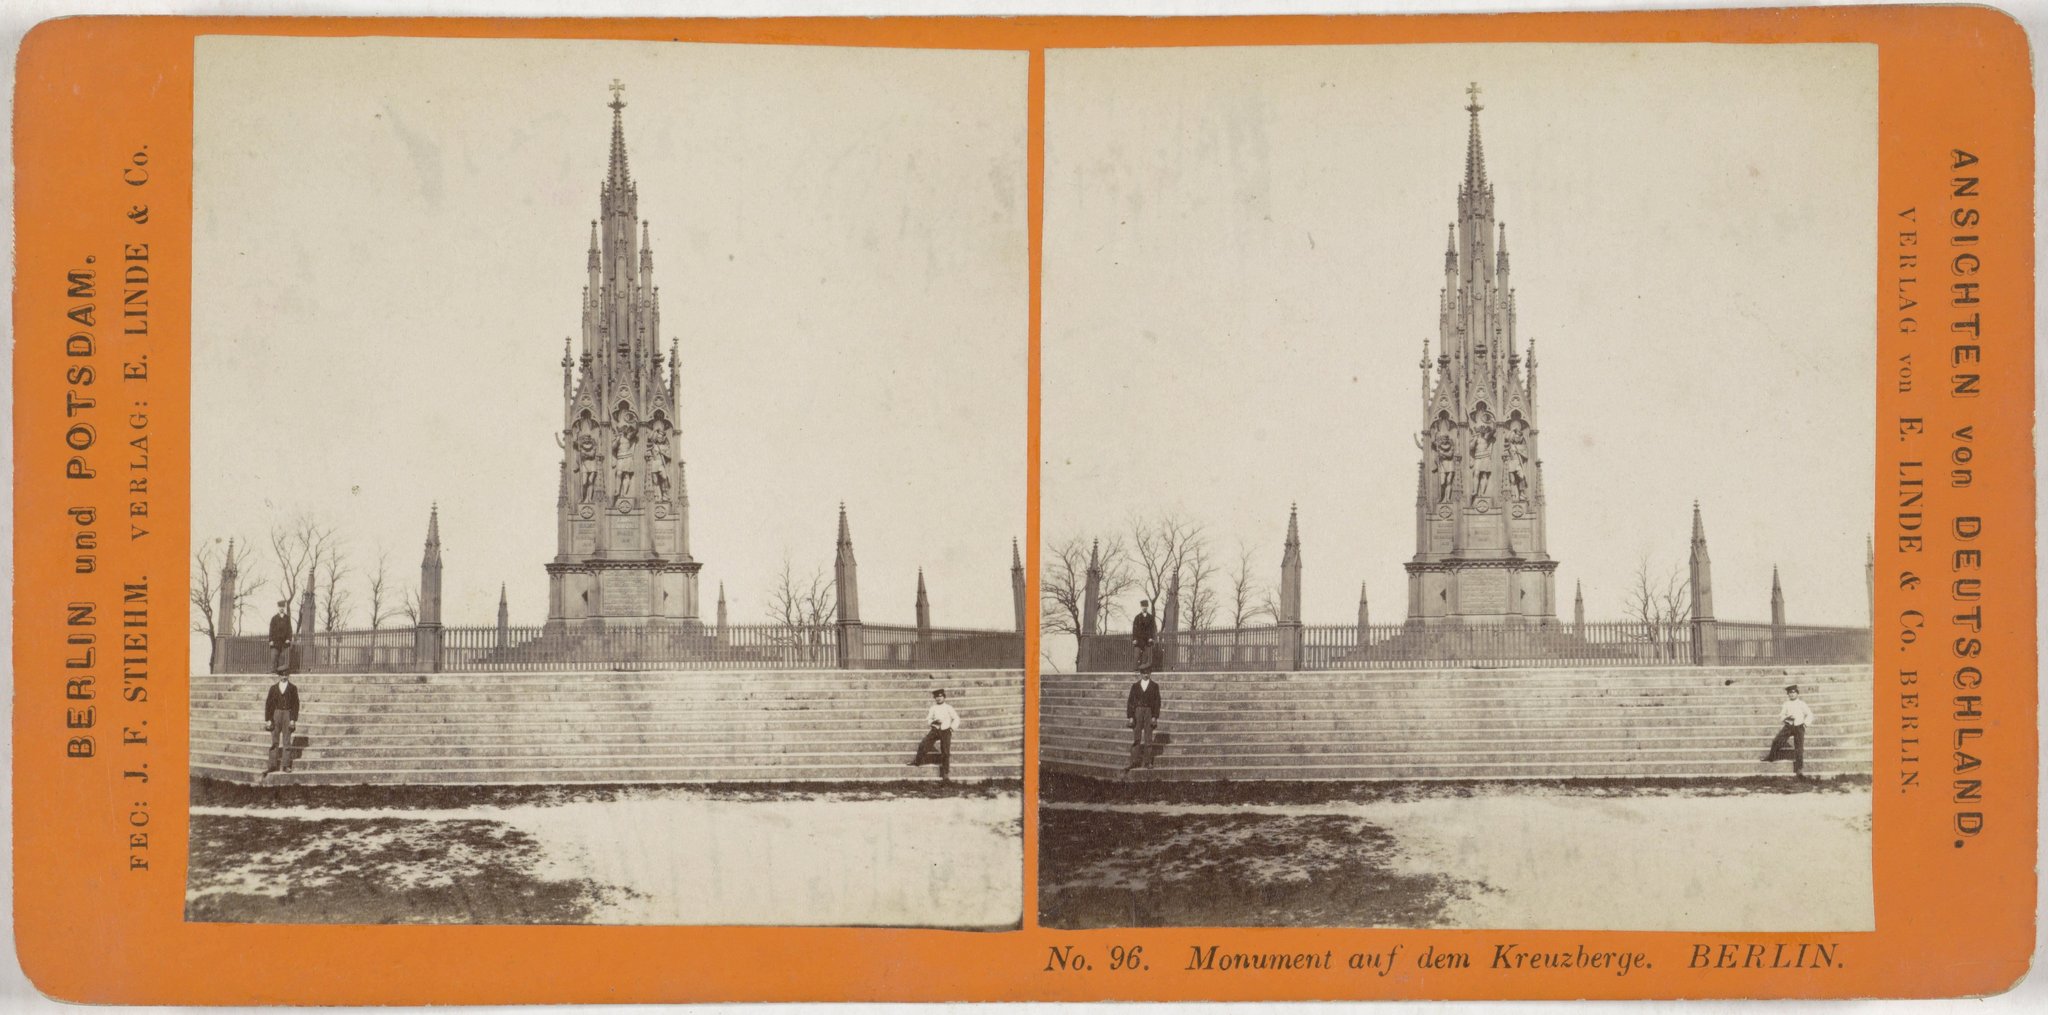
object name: stereograph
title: Ansichten von Deutschland / Berlin und Potsdam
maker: johann friedrich stiehm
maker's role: fotograaf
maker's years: 1826-1902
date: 1868-1870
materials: cardboard, paper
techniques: albumen print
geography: berlin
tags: monument, statue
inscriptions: number: ‘No. 96’